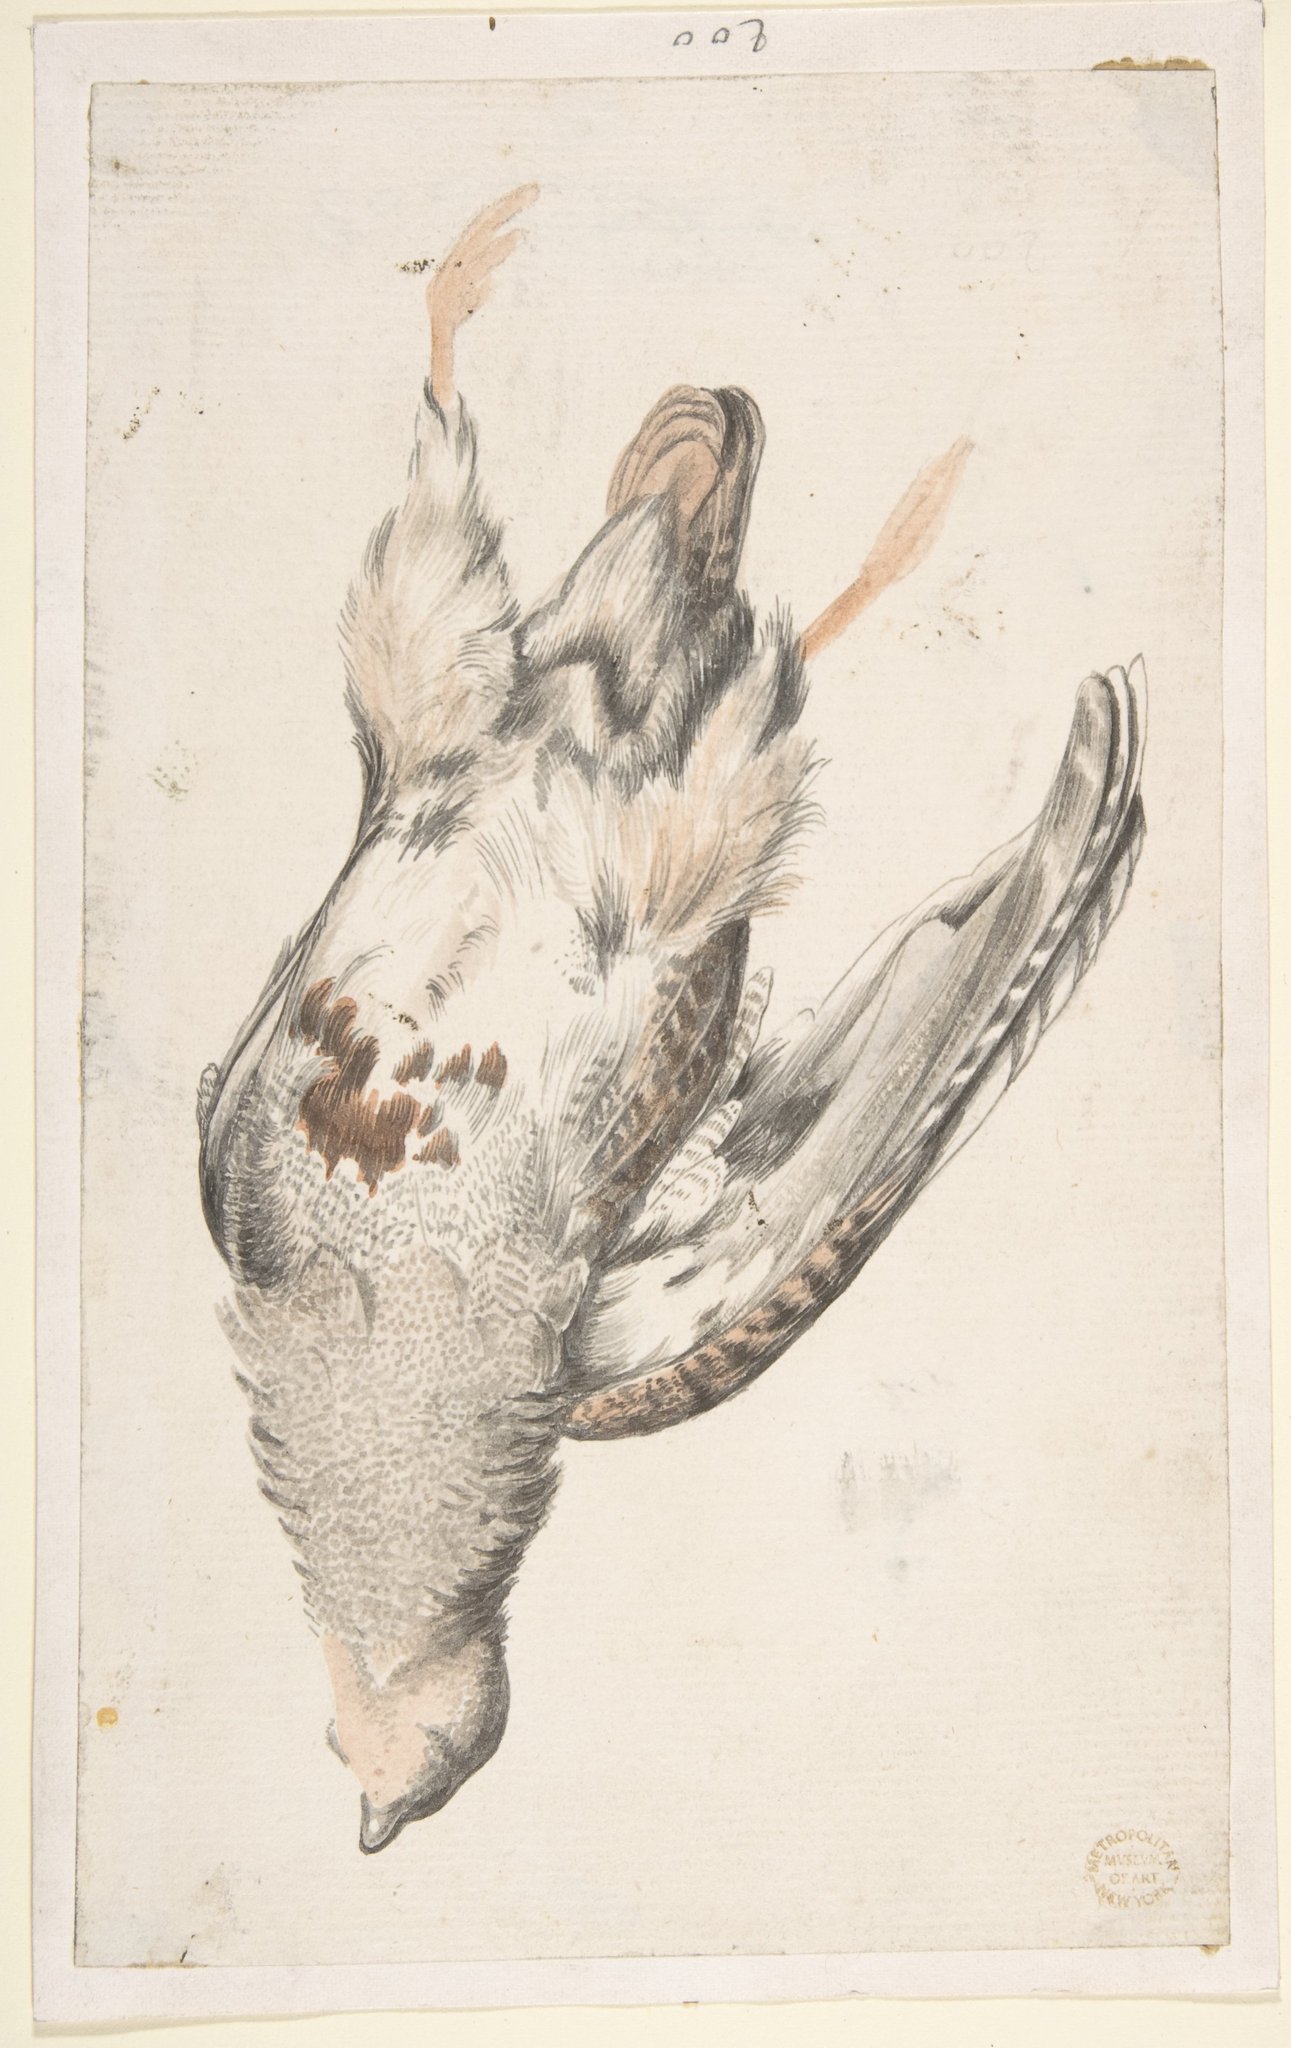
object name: drawing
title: A Dead Bird (Quail?) Seen from Below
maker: count giorgio durante (duranti)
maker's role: artist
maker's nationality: italian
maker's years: 1685-1755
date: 1685-1755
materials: graphite, watercolor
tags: birds